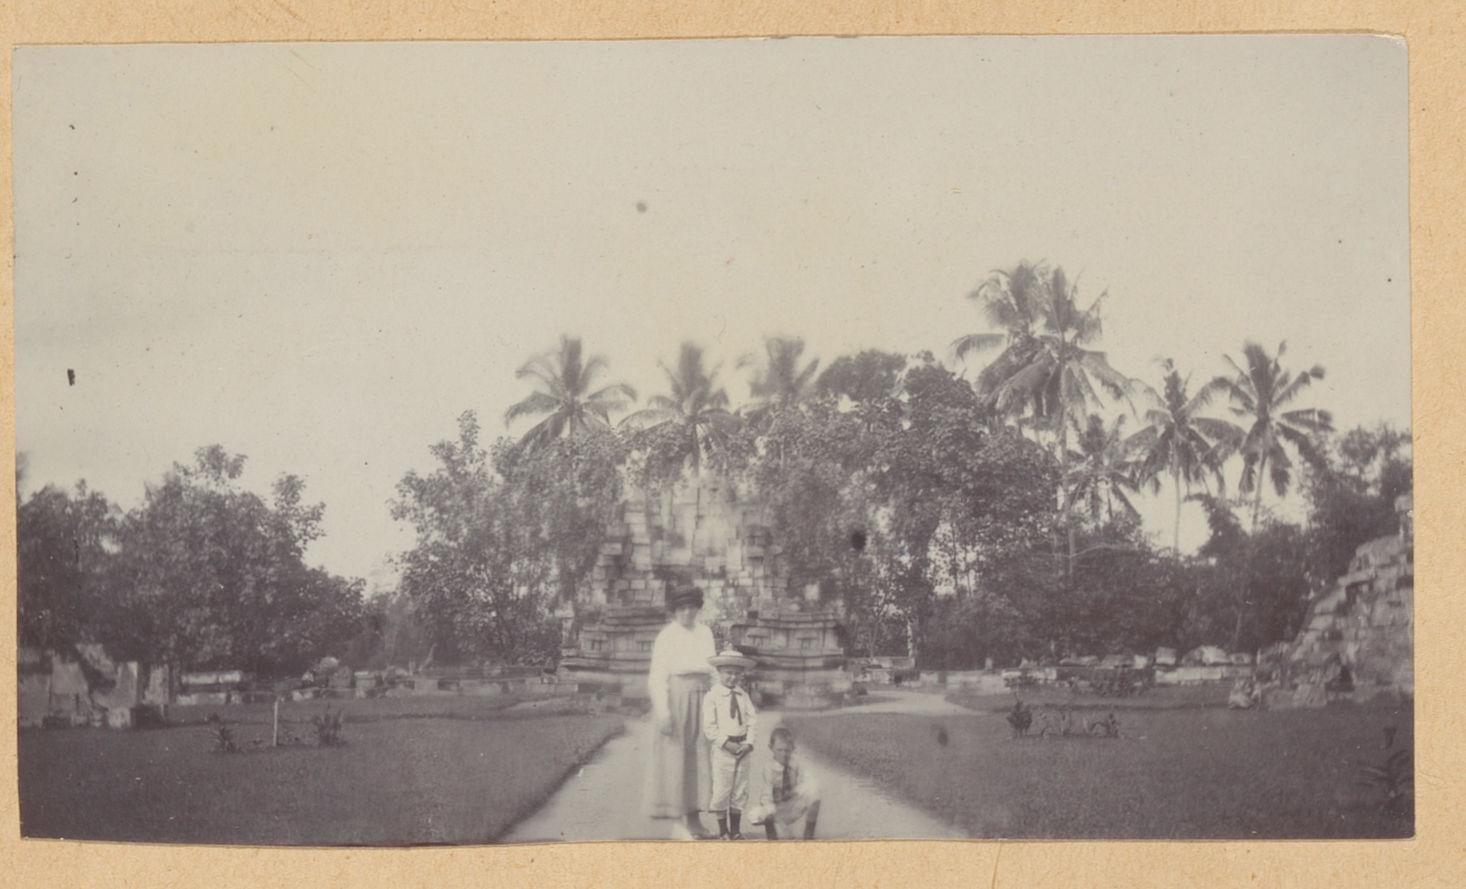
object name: photograph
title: Vrouw met twee kinderen bij een oud bouwwerk, mogelijk de Borobudur op Java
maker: Anonymous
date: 1916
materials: photographic support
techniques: gelatin silver print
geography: borobudur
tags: temple, shrine ~ hinduism, buddhism, jainism, mother and child(ren), woman and child(ren) (family group)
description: Onderdeel van Familiealbum met foto's van een familie in de voormalige kolonie Nederlands-Indië en van een suikerfabriek in Purworejo.